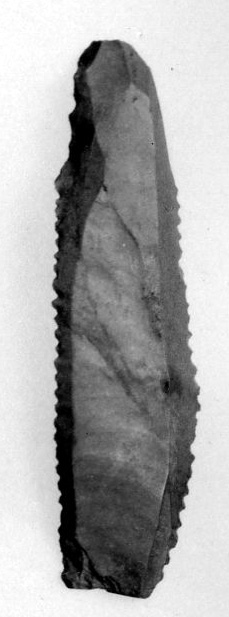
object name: tool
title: Tool (?)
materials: stone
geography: egypt